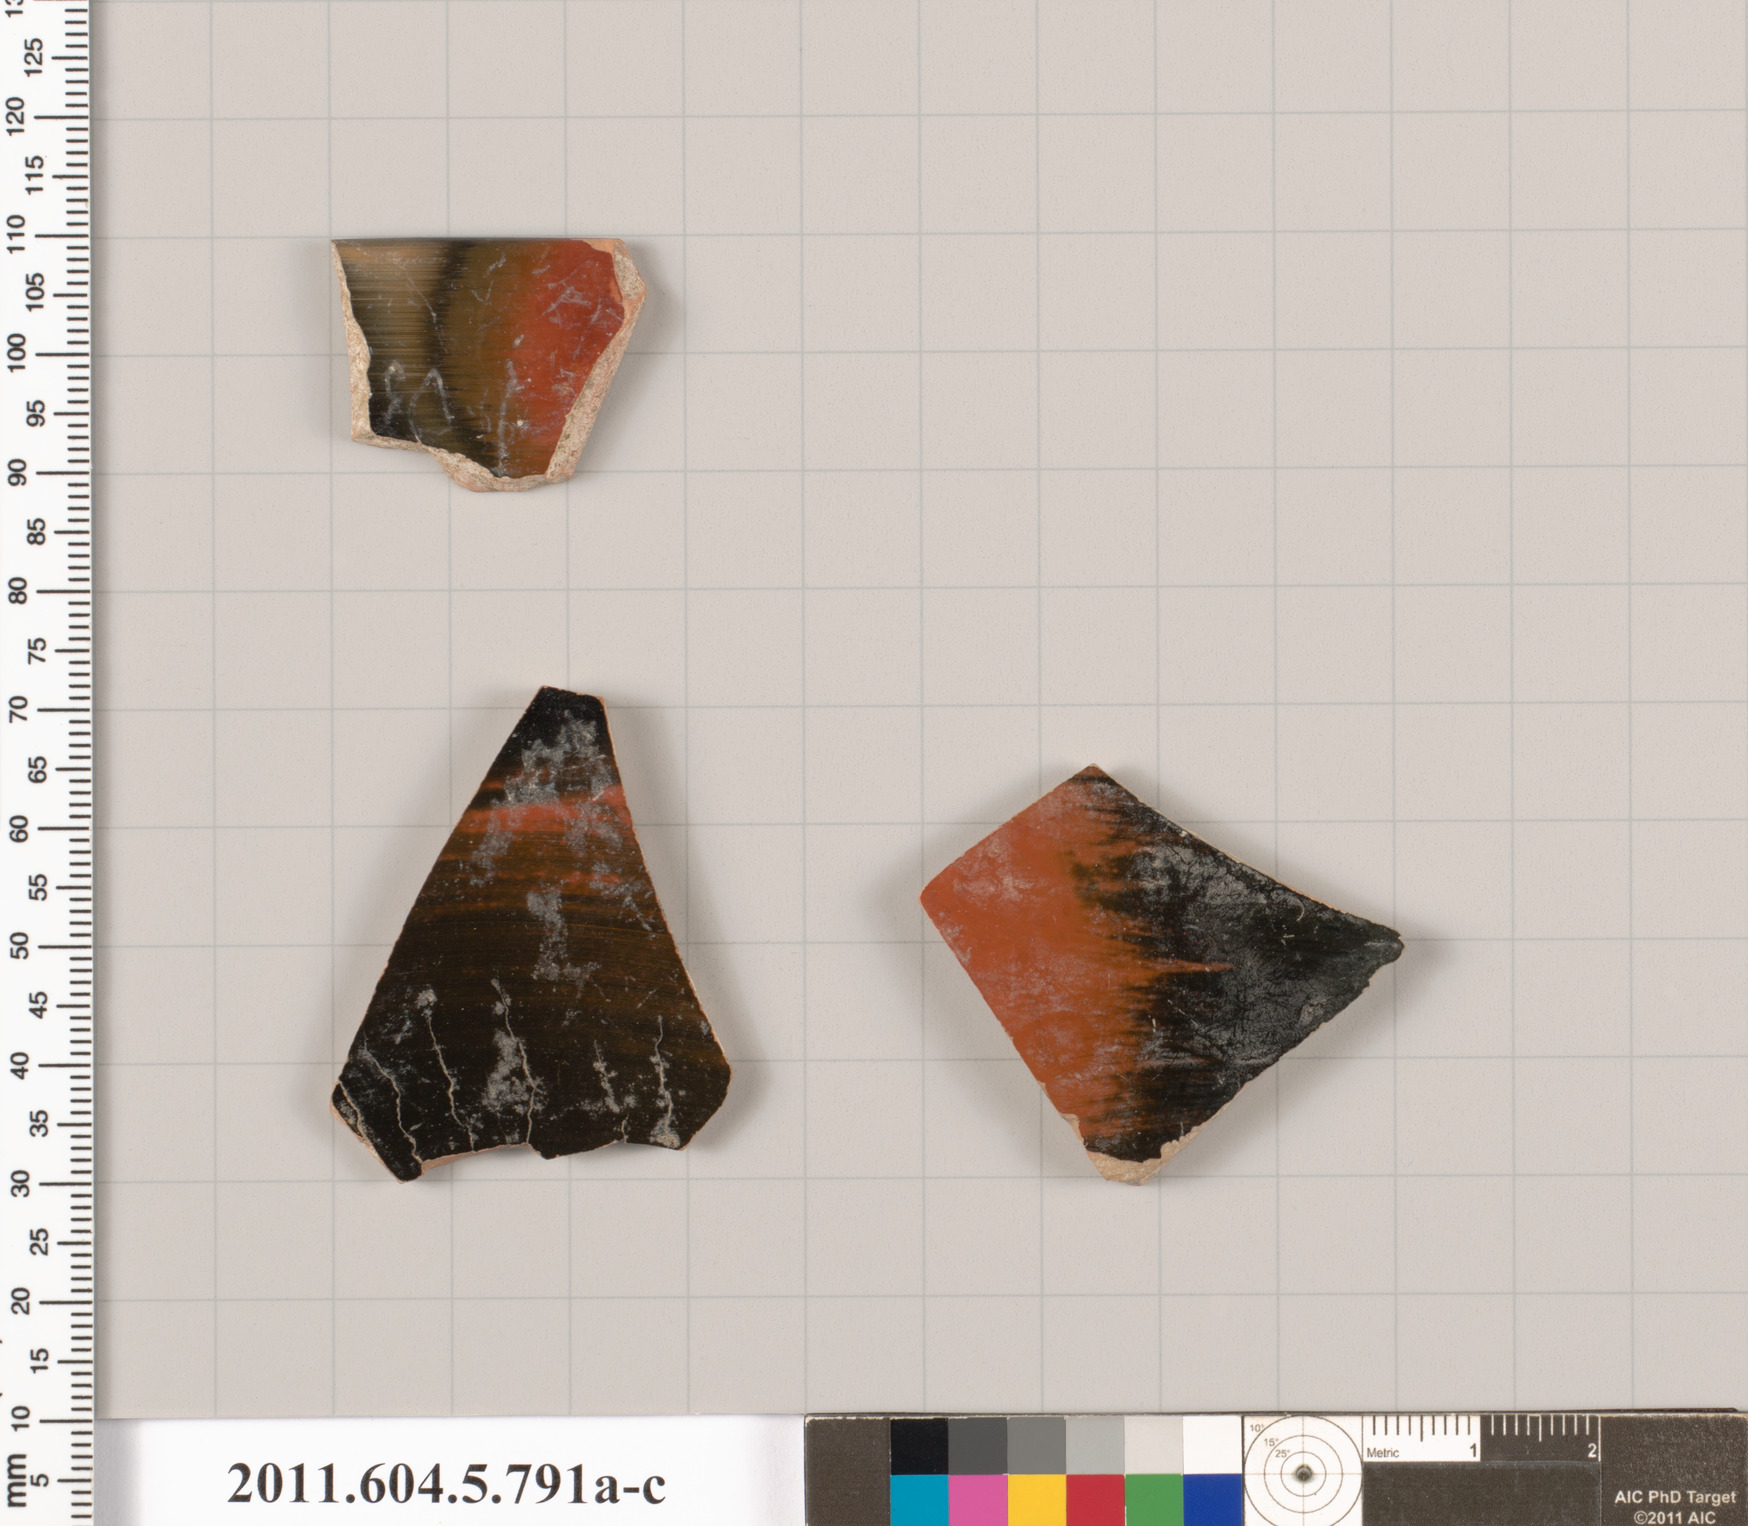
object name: kylix fragment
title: Terracotta fragments of a kylix (drinking cup)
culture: greek, attic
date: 600-401 BCE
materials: terracotta